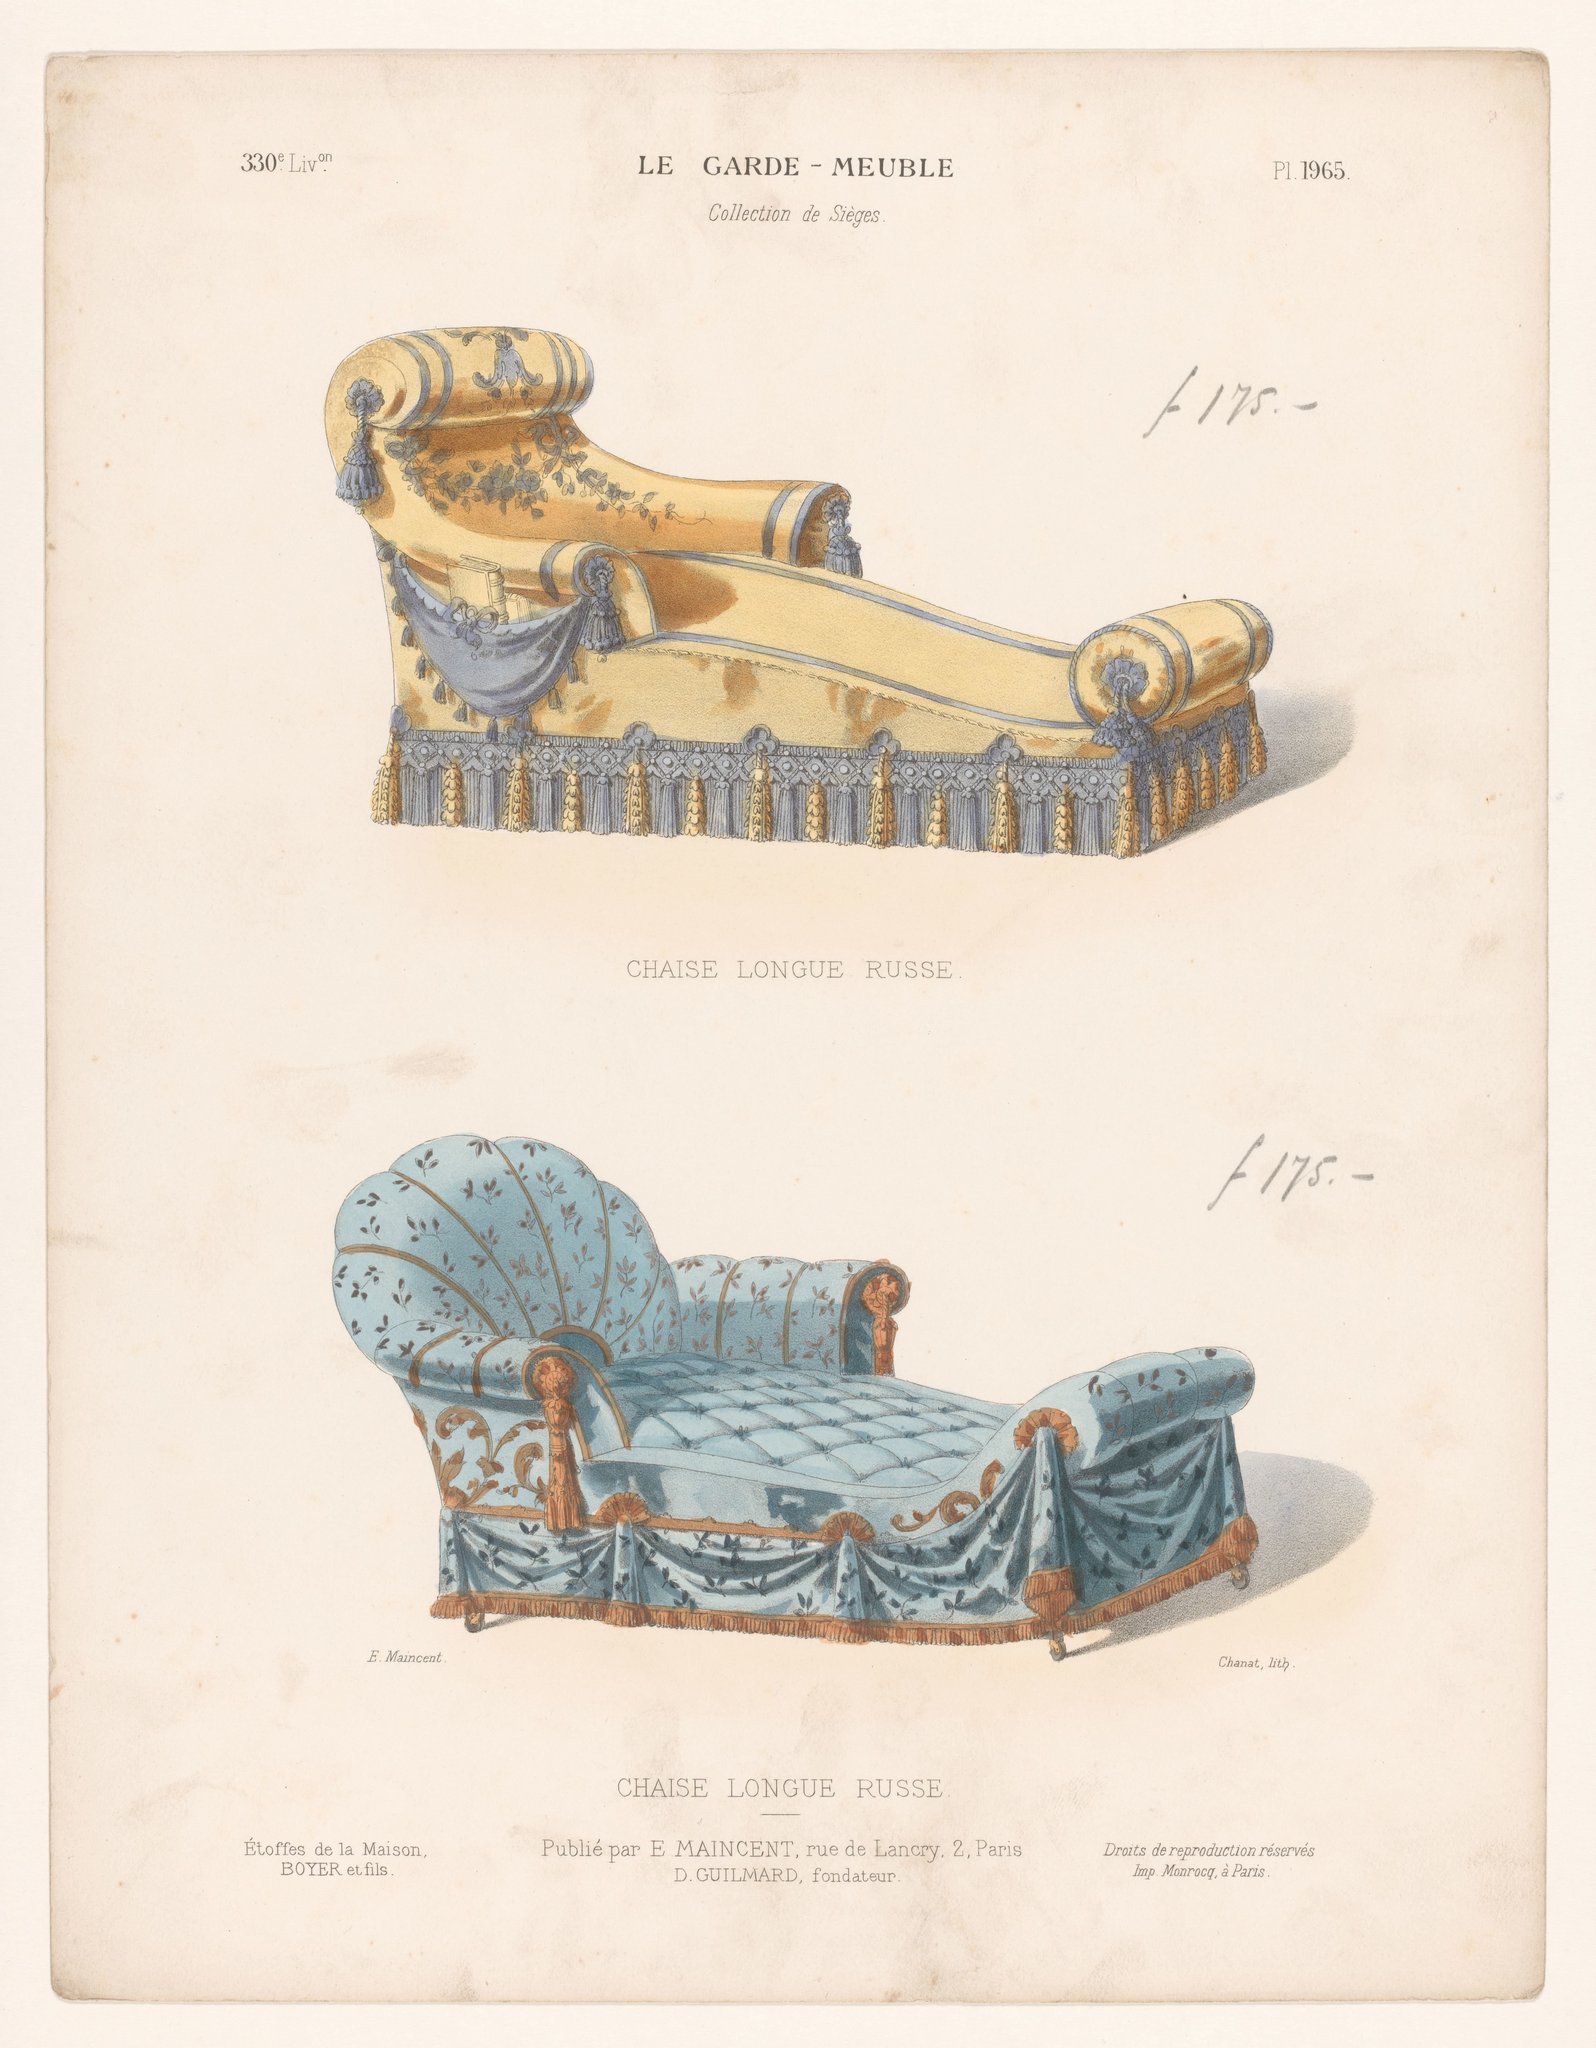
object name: print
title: Chaise longue Russe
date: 1885-1895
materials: paper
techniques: hand coloring, lithograph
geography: paris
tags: seating furniture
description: Ieder Livraison in de serie Le Garde-Meuble bevat negen platen: drie 'sièges' (zitmeubels), drie 'meubles' (diverse meubels zoals tafels en kasten) en drie 'tentures' (gordijnen en draperieën).